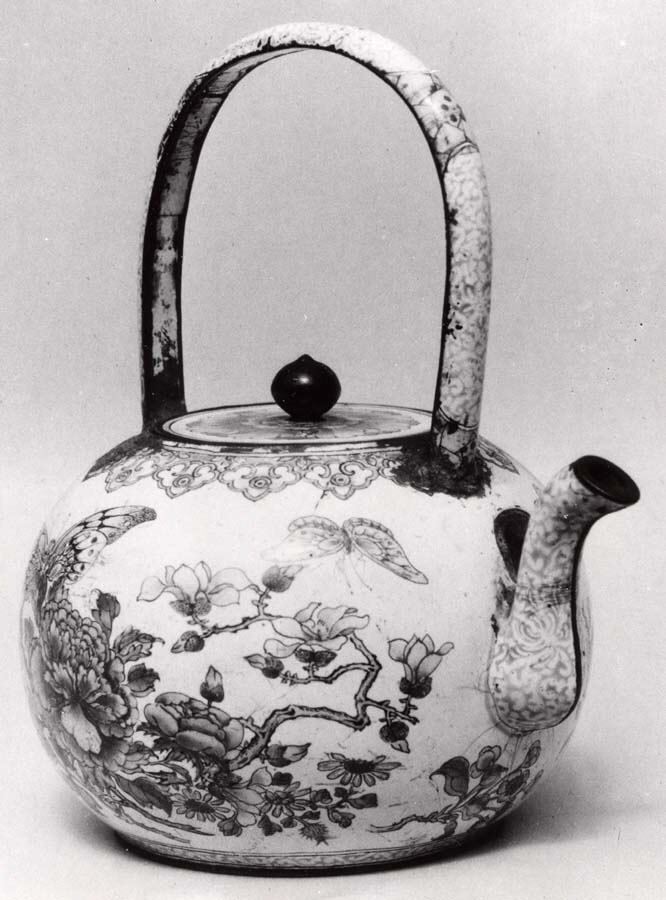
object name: teapot with cover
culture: chinese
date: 1801-1900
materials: enamel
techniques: painting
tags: butterflies